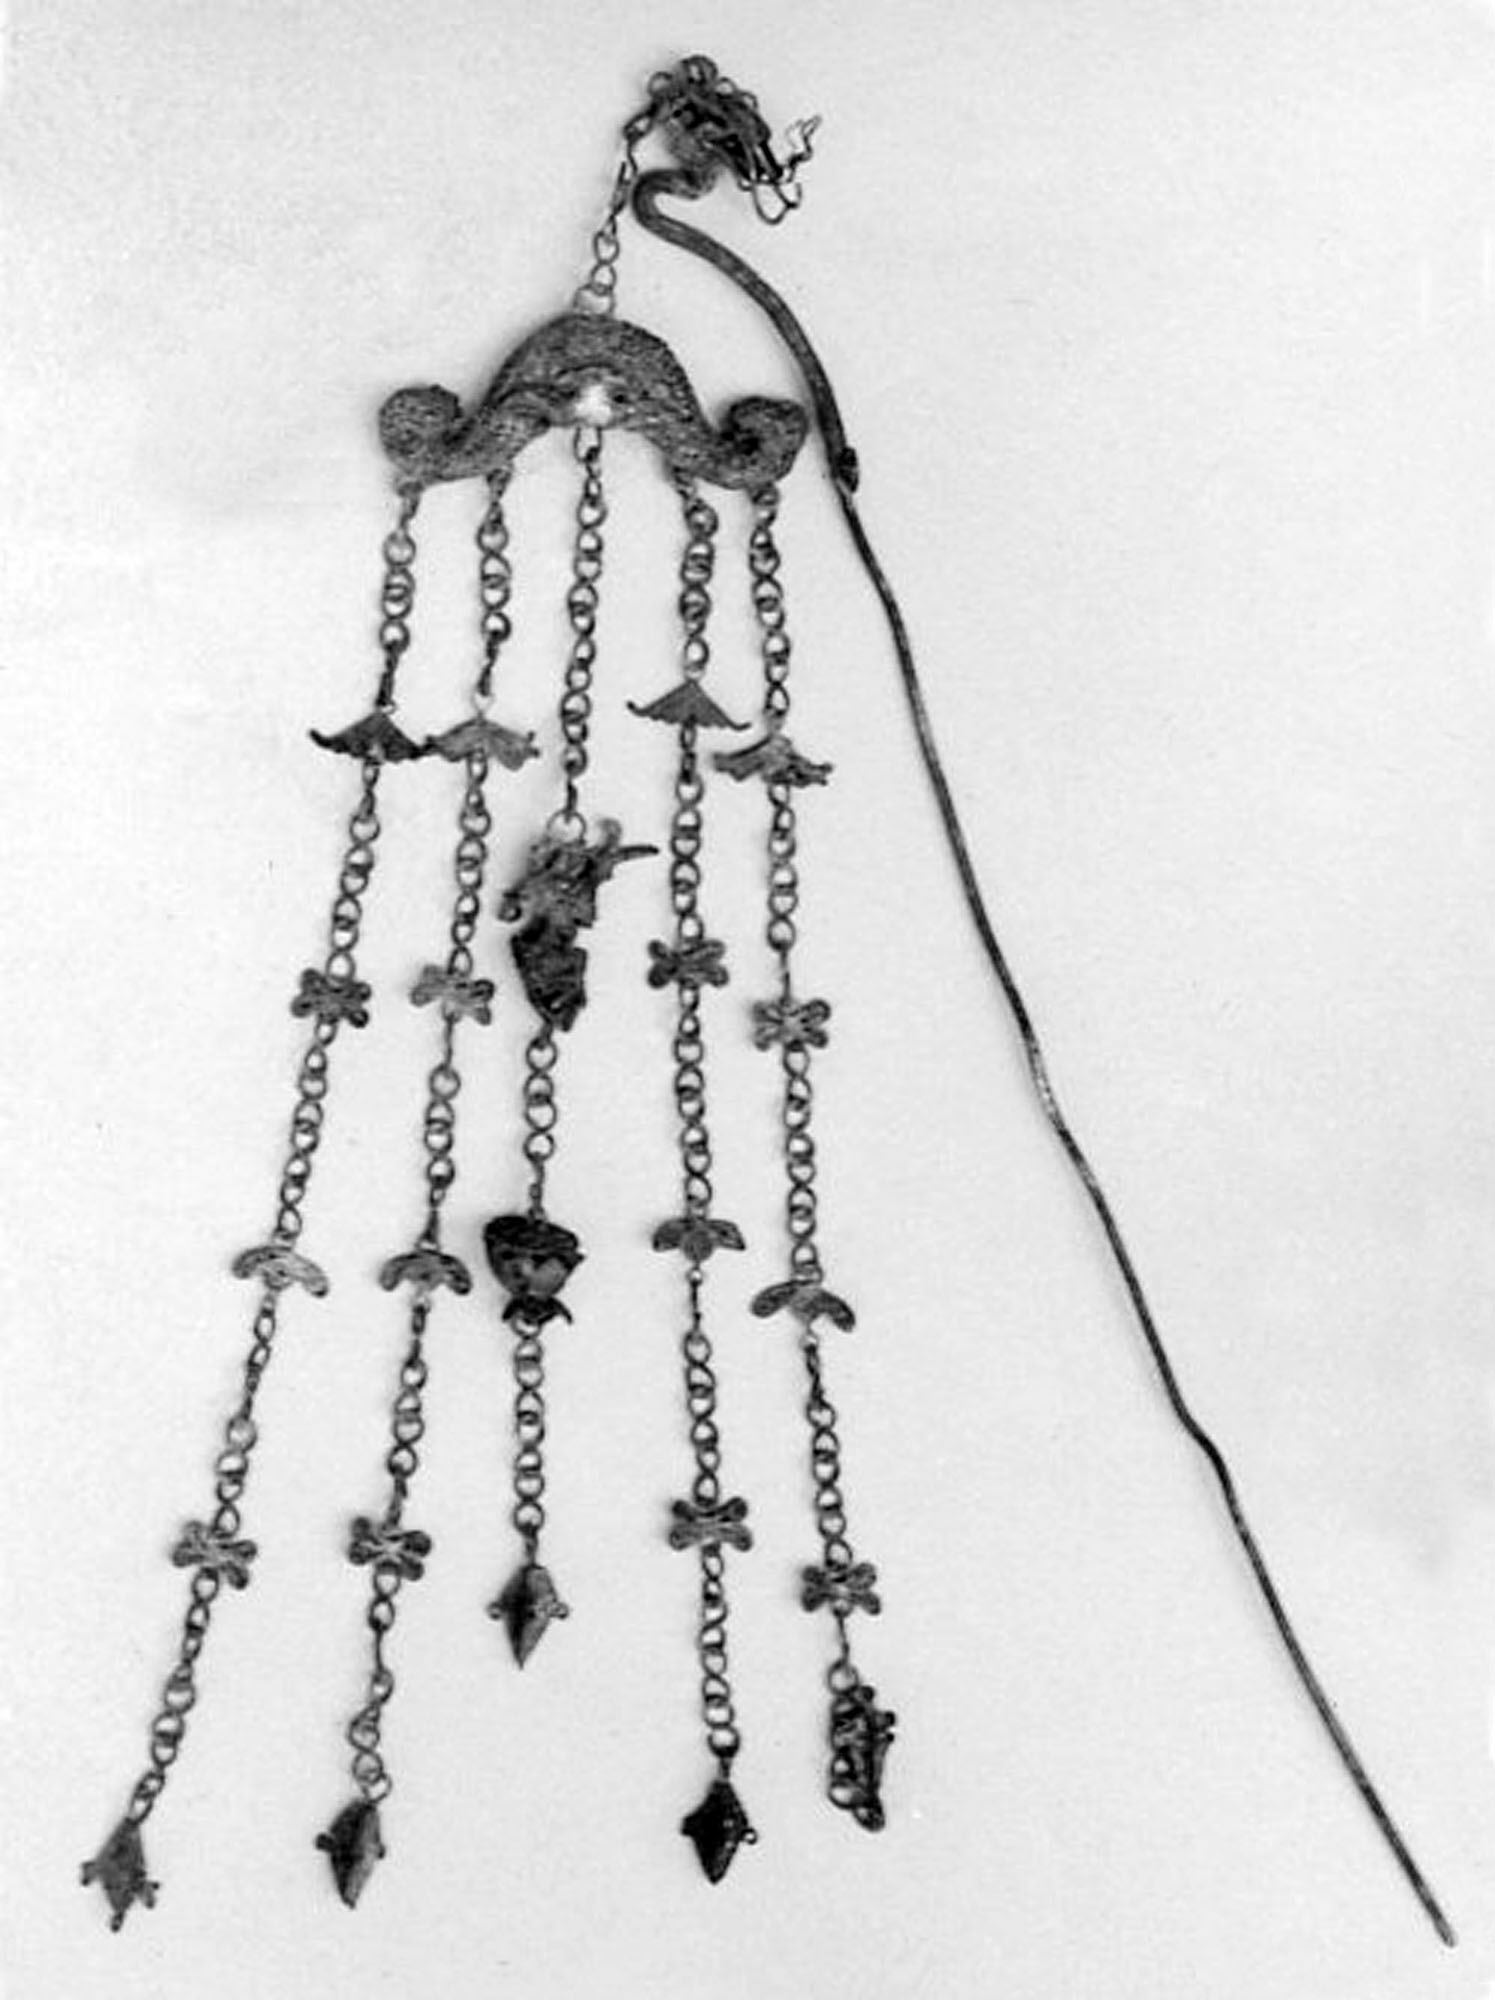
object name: hair ornament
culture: chinese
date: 1368-1644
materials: silver